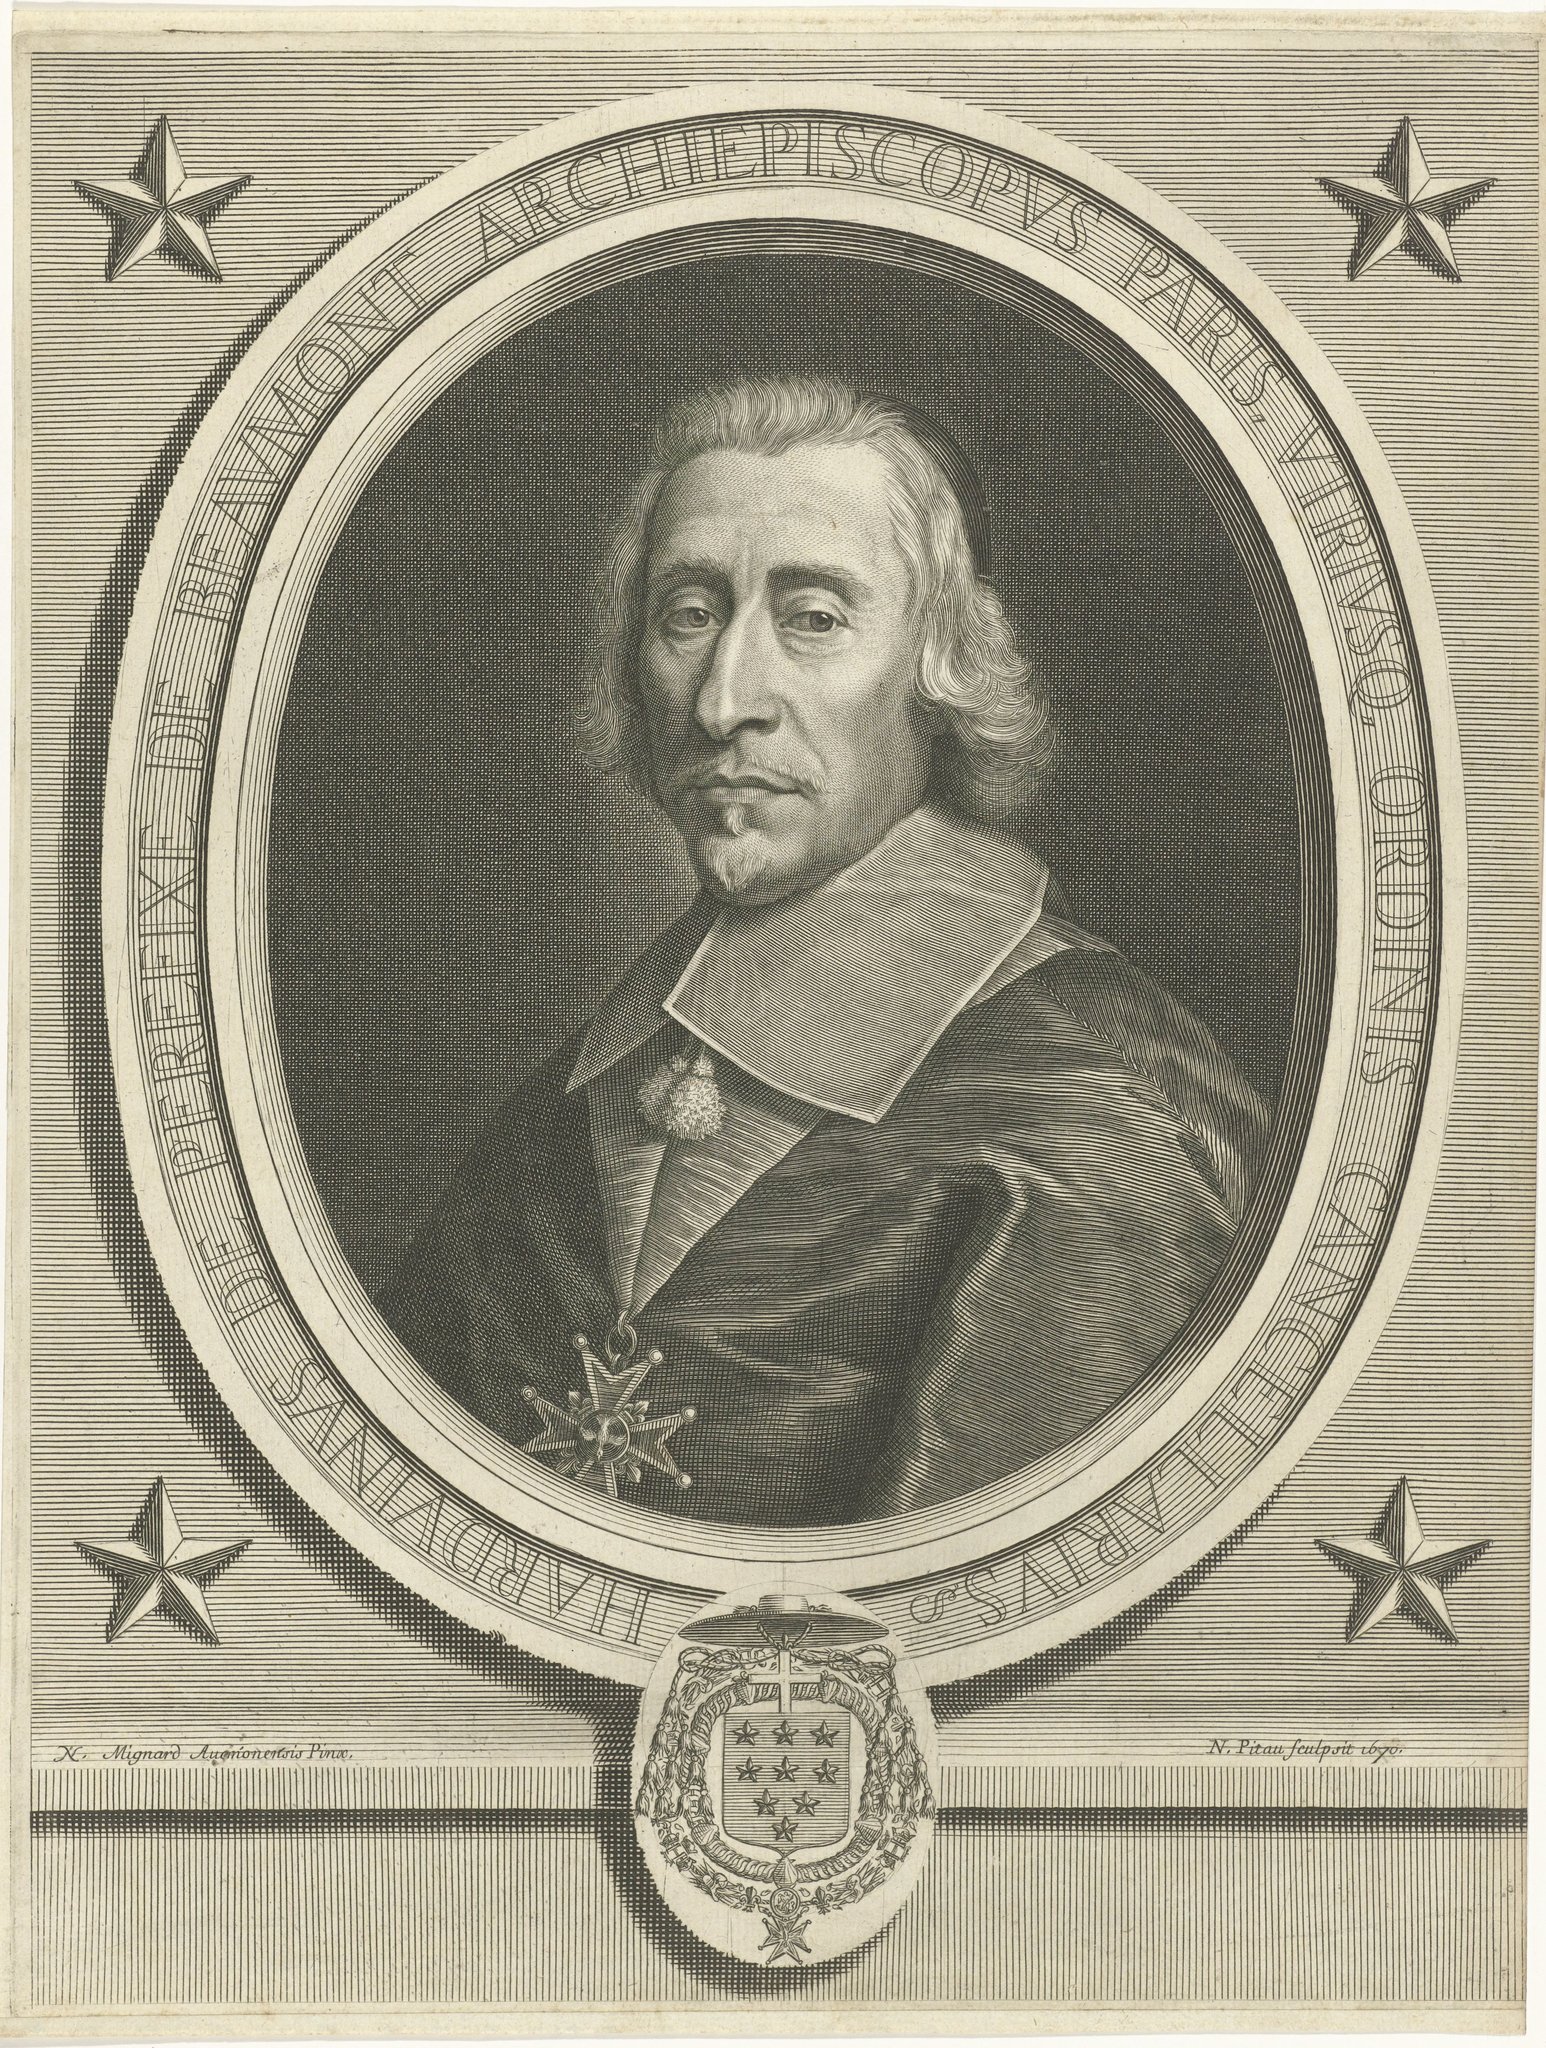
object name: print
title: Portret van Hardouin de Beaumont de Péréfixe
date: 1670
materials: paper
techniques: engraving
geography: paris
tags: paris, archbishop, bishop, etc. (roman catholic), knighthood order of the holy spirit, armorial bearing, heraldry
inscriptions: collector's mark: Lugt 2228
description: Portret van de Franse aartsbisschop Hardouin de Beaumont de Péréfixe. Hij draagt een lint met de hanger van de Orde van de Heilige Geest. Op de piëdestal zijn wapenschild.